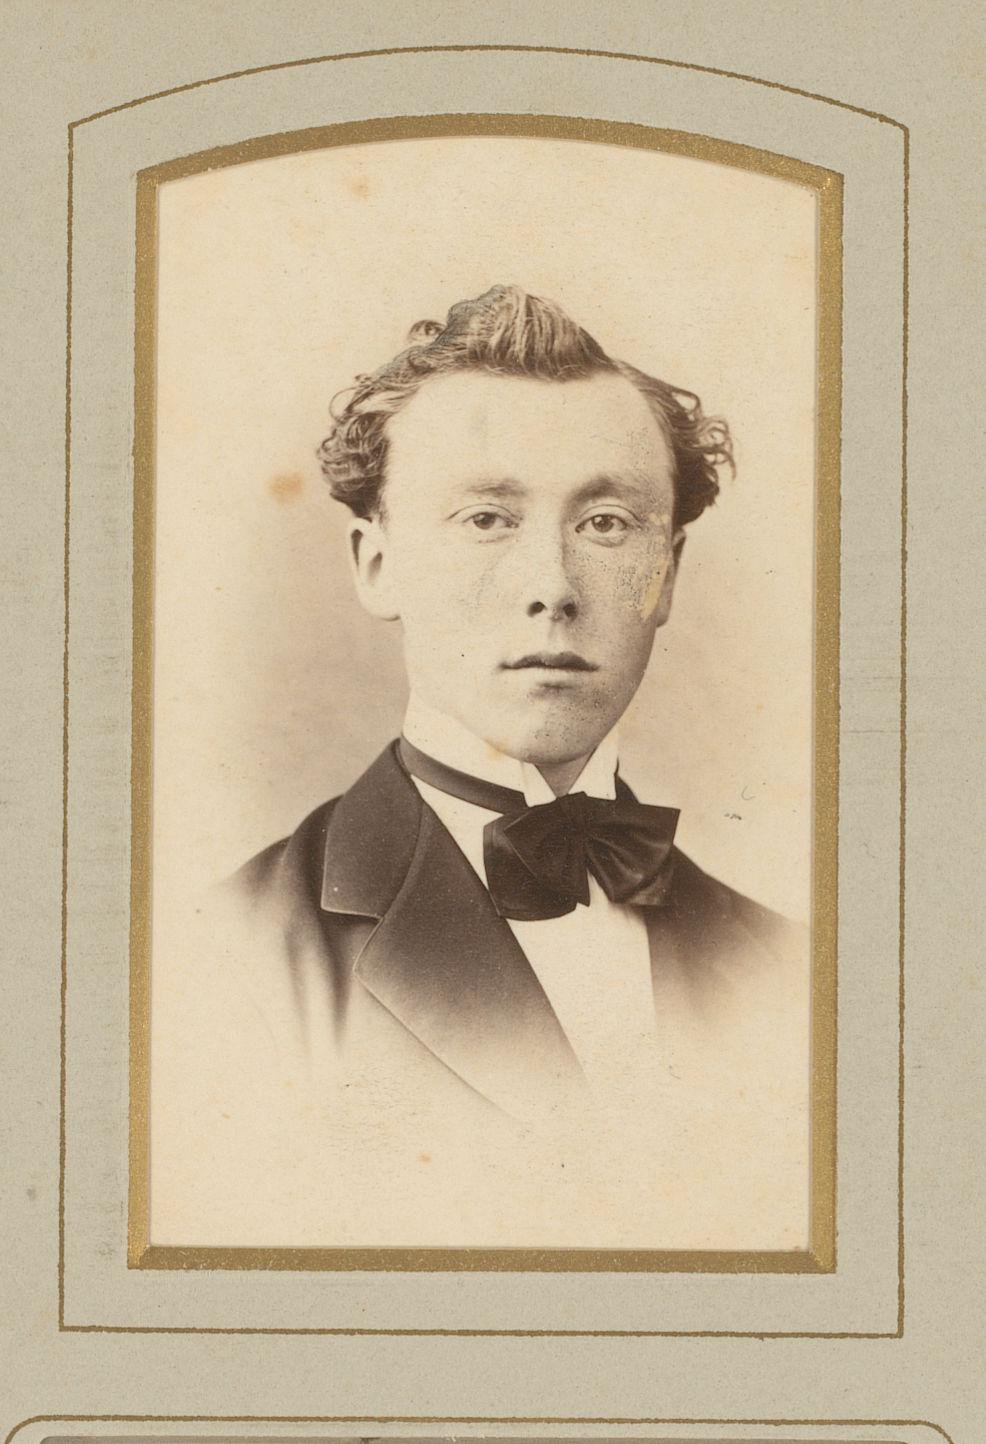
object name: photograph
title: Portret van een jonge man met vlinderstrik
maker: palmer descamps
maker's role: goldsmith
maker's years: 1840-1884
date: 1865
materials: cardboard, photographic support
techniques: albumen print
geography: kortrijk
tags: historical persons, youth, adolescent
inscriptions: inscription: ‘COURTRAI/ RUE DE LA LYS, 13./ PHOTOGRAPHIE/ Descamps/ PALMER/ ORFÈVRERIE’